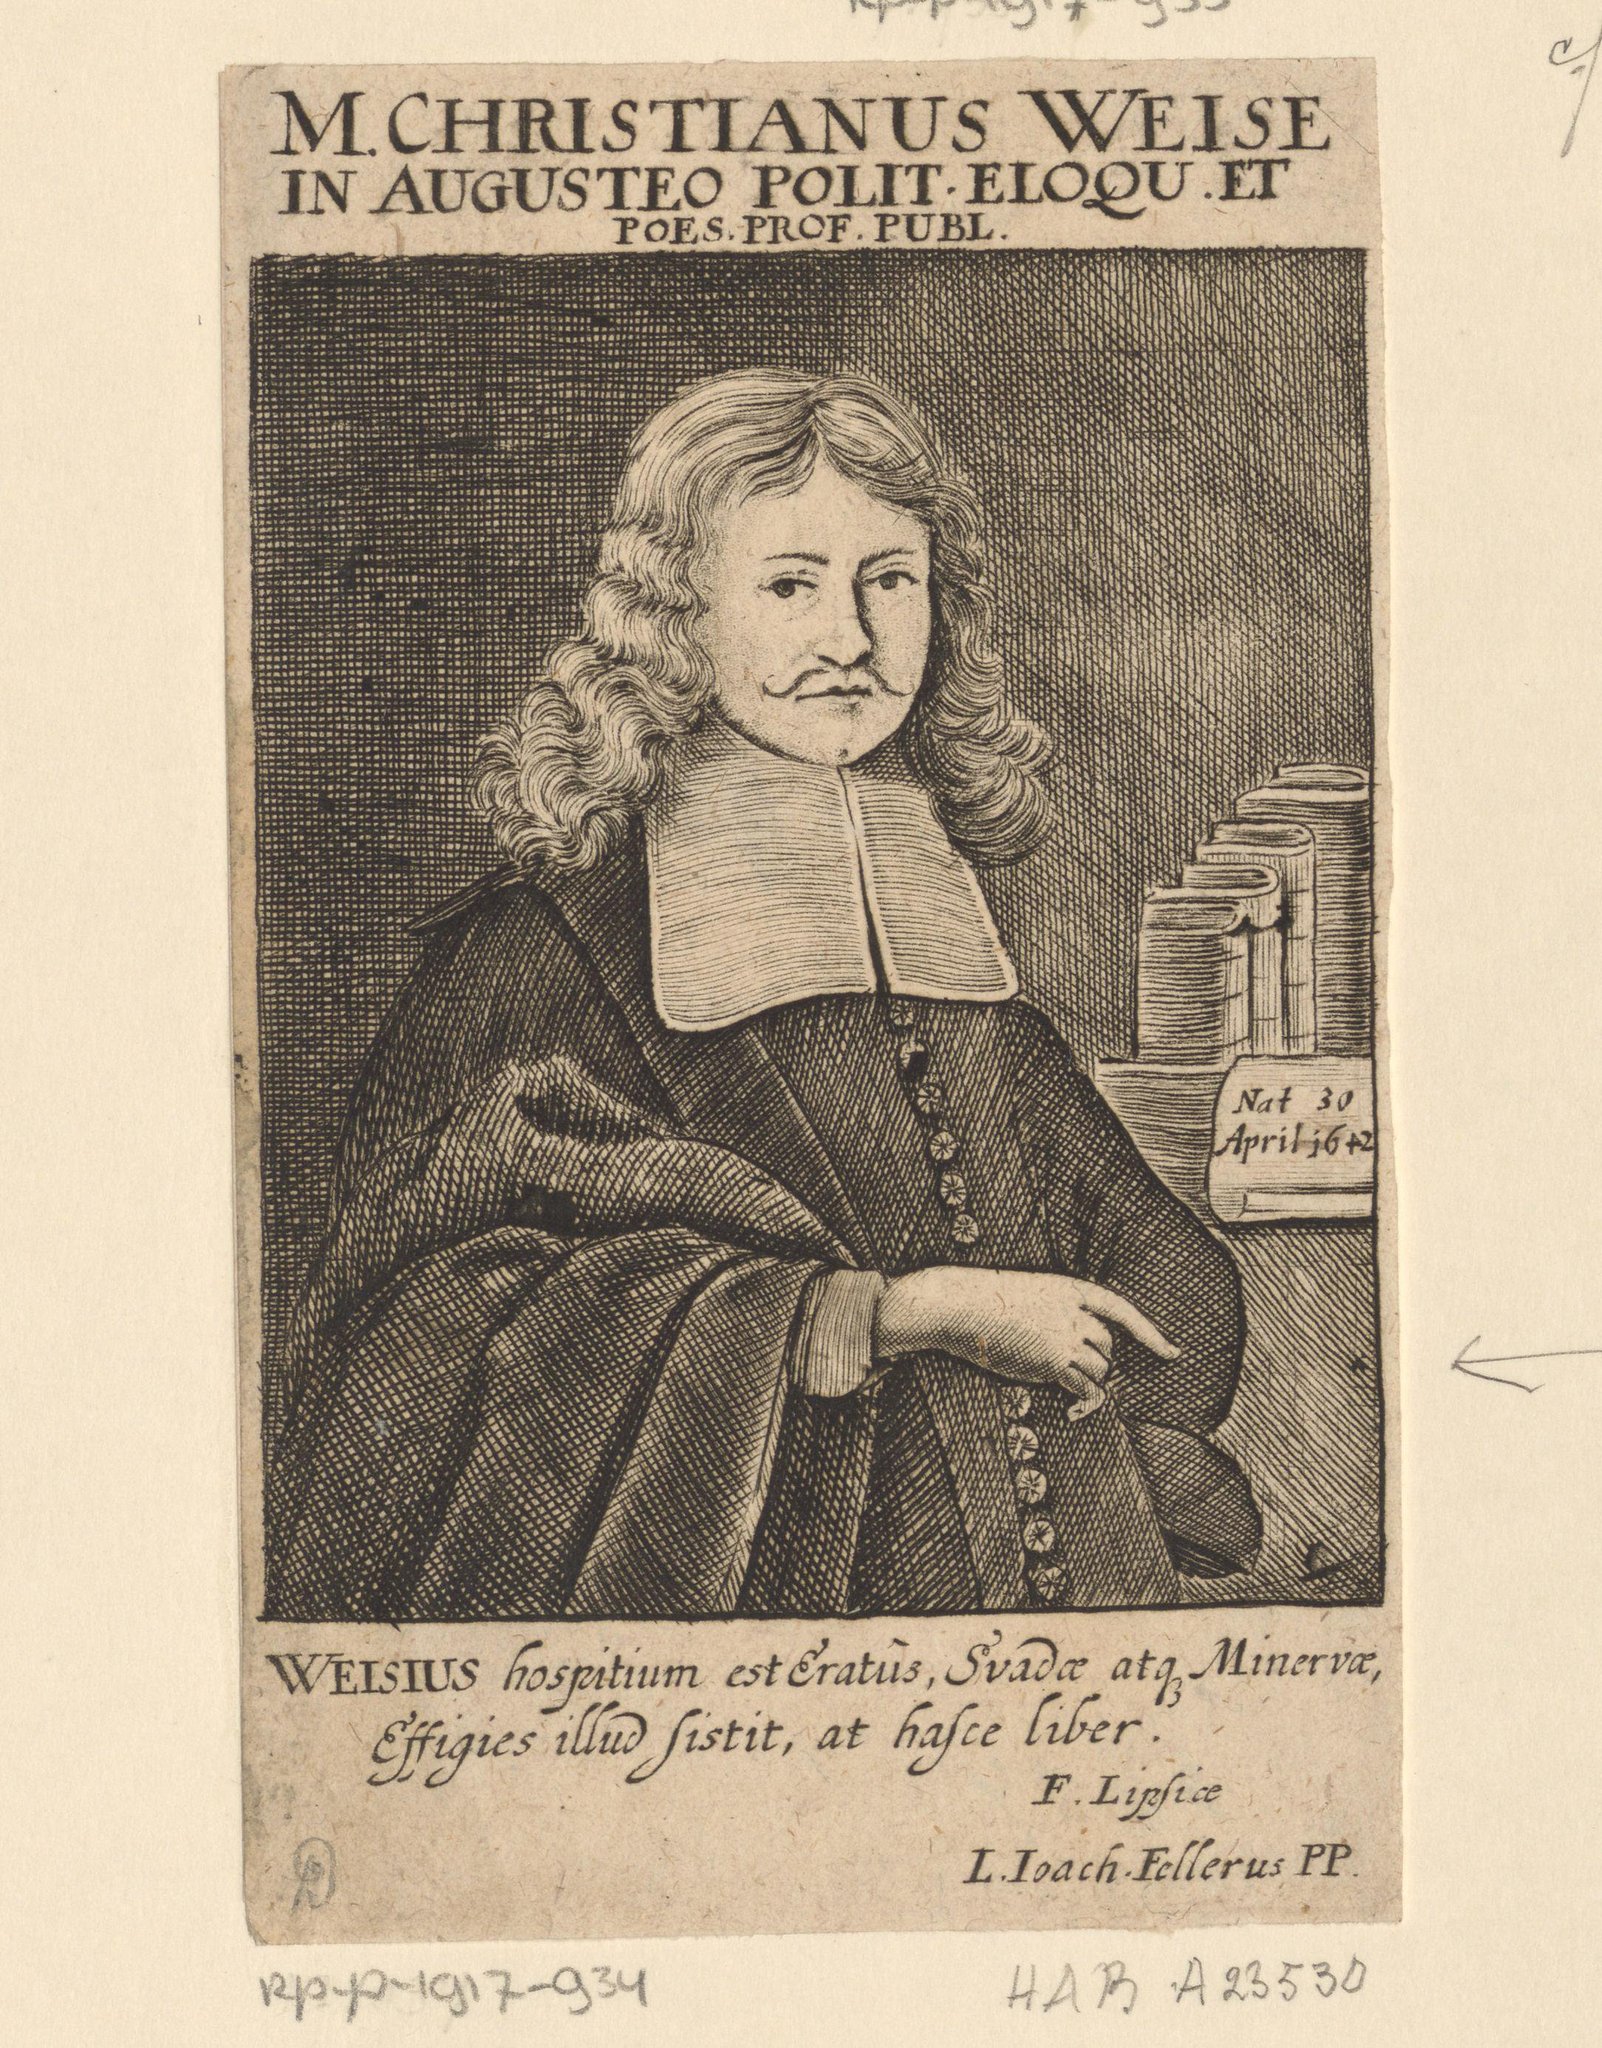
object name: print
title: Portret van Christian Weise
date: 1679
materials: paper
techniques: engraving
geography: leipzig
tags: bookshelves, historical persons, portrait of a writer, professor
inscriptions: collector's mark: Lugt 2228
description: Prent waarschijnlijk uit: Weise, Christian. Christian Weisens Politischer Redner, Das ist, Kurtze und eigentliche Nachricht (...). Leipzig: Jacob Gerdesius, 1679. In andere uitgaven van dit werk zitten portretten van de auteur die erg op deze prent lijken maar wel verschillende prenten zijn, zie ook: RP-P-2022-5184 en RP-P-1917-935.